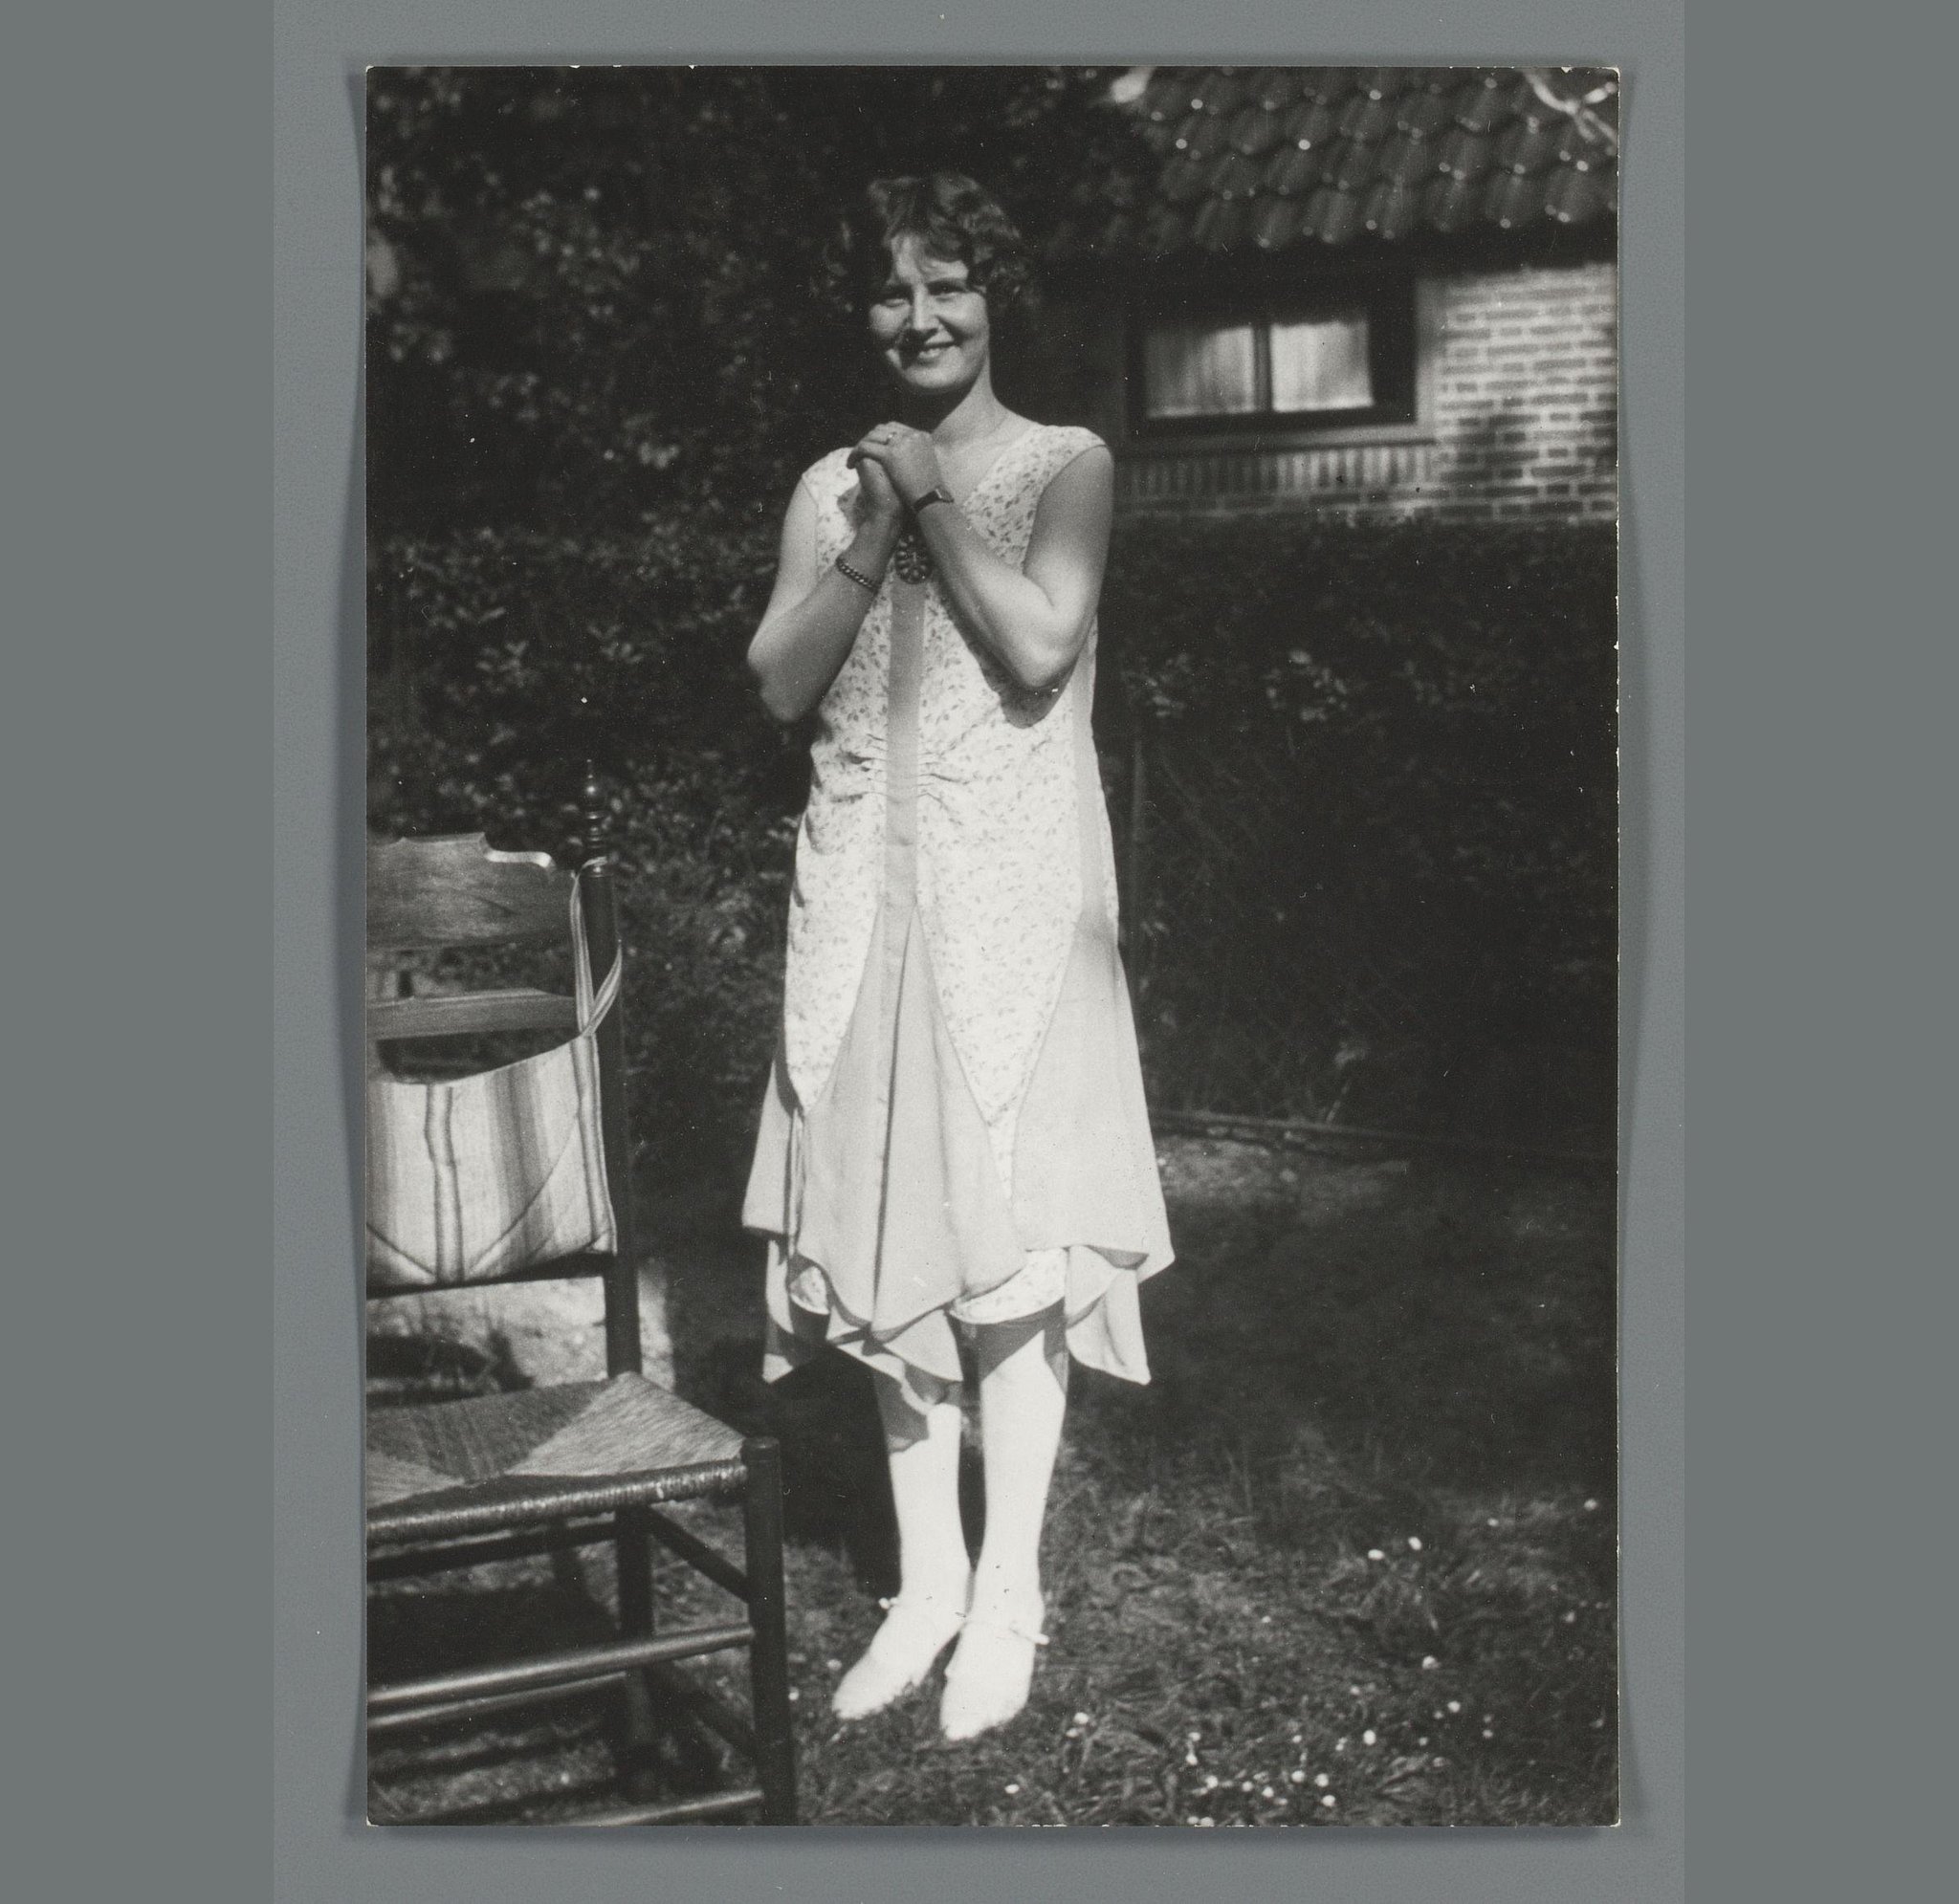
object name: photograph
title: Portret van een onbekende vrouw in een tuin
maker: Anonymous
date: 1920-1950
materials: paper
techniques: gelatin silver print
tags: historical persons not known by name - bb - woman, garden